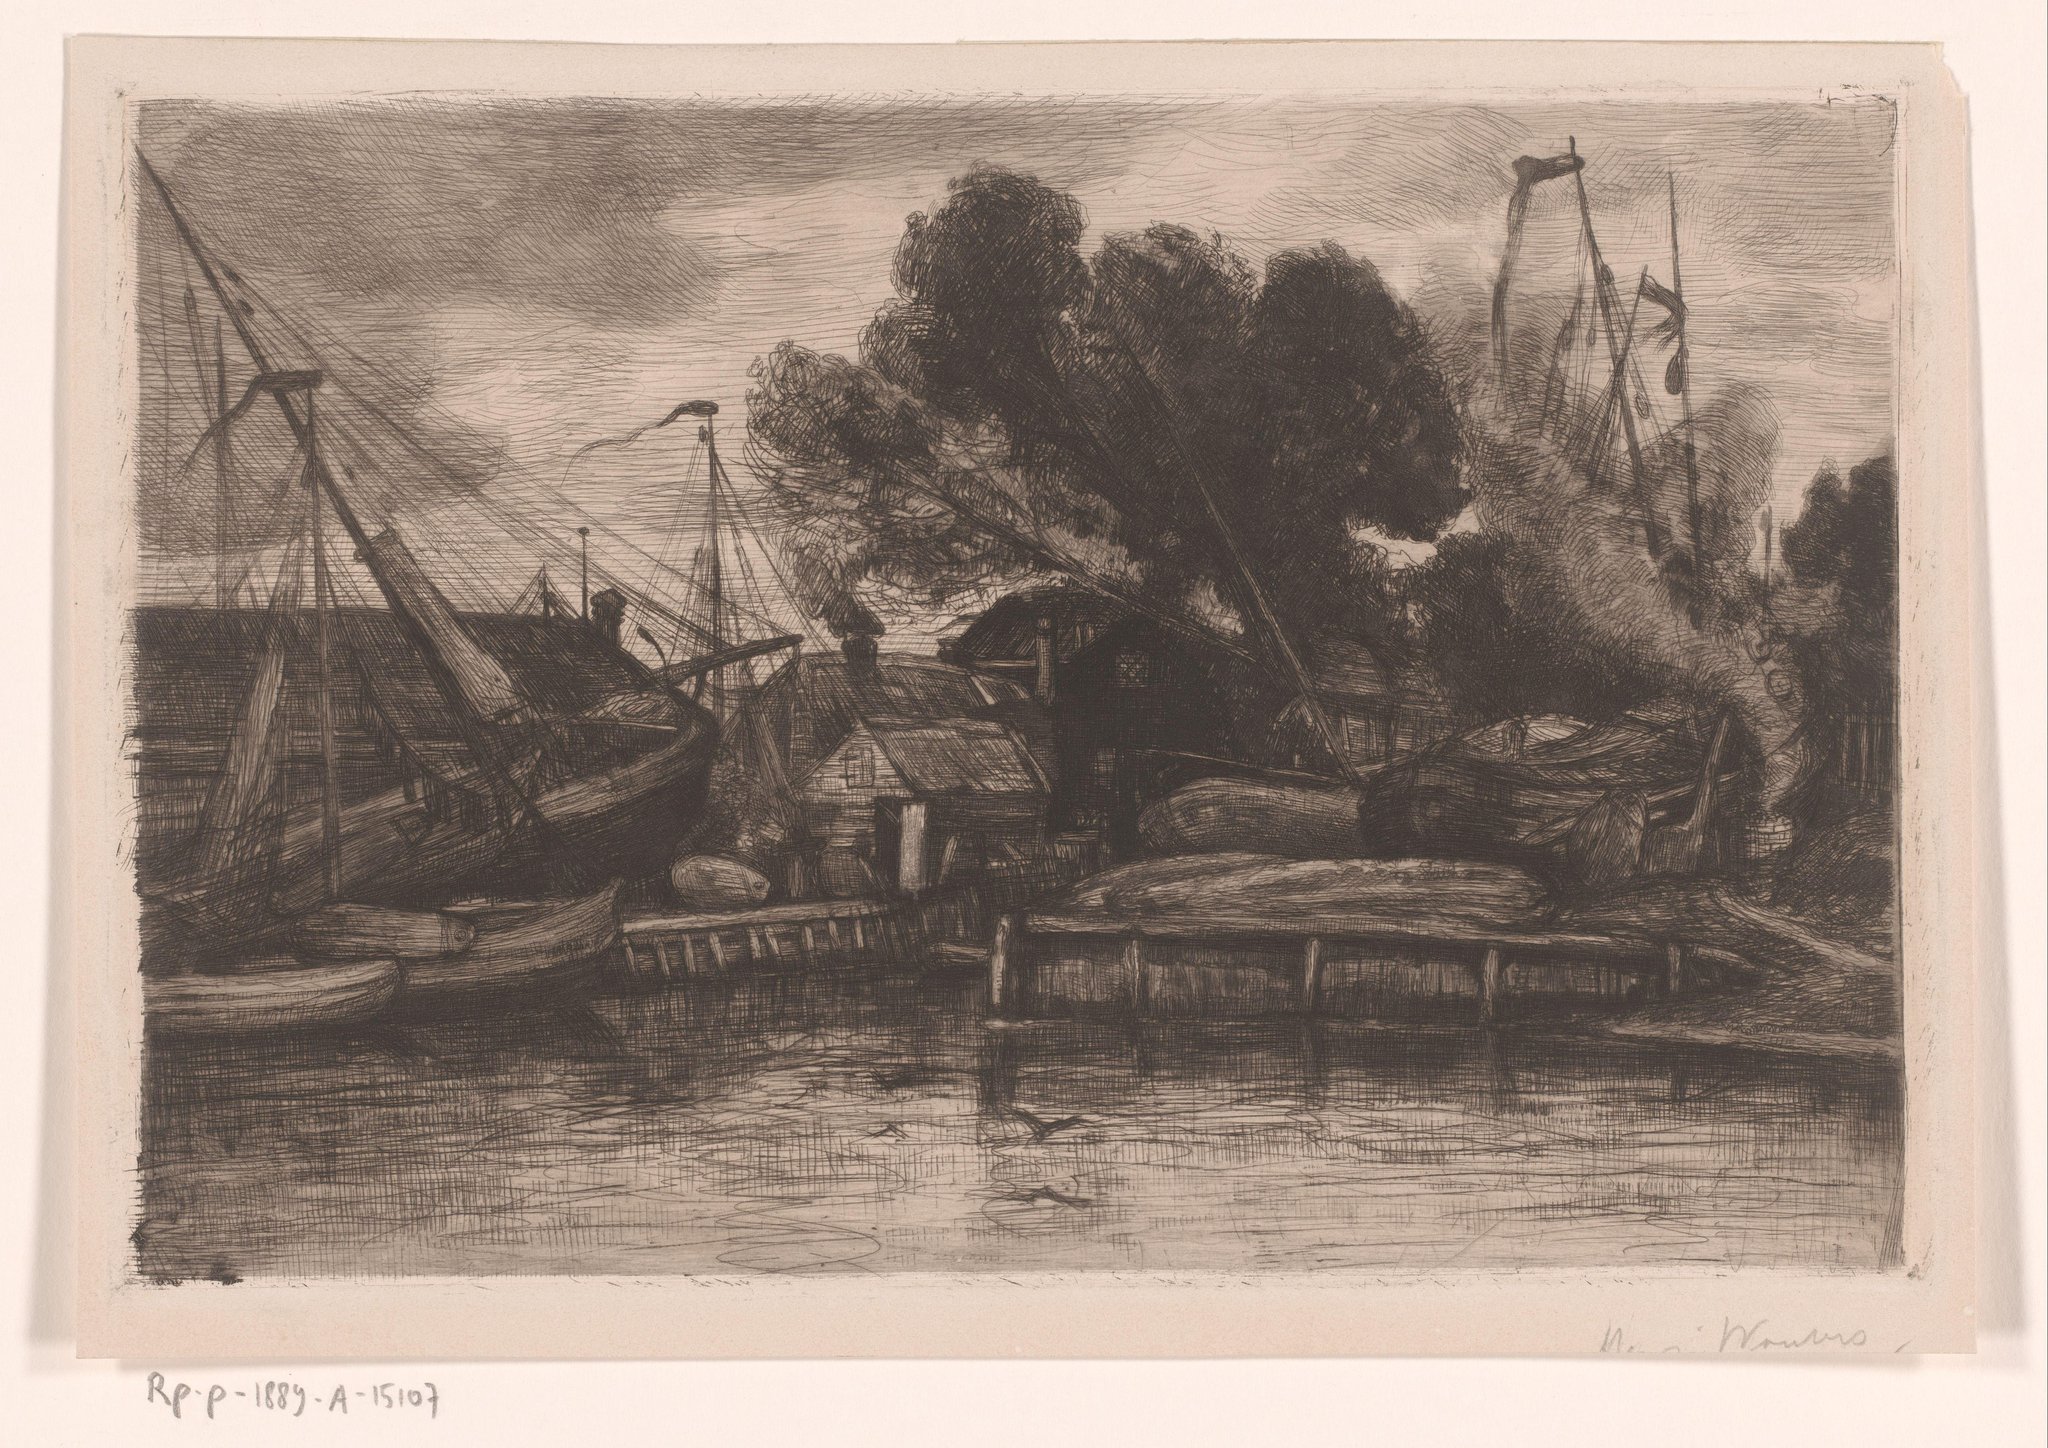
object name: print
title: Scheepswerf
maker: henri wouters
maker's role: draughtsman, print maker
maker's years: 1866-1935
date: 1876-1889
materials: paper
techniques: drypoint, etching, intaglio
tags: shipyard, shipdock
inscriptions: collector's mark: Lugt 2228